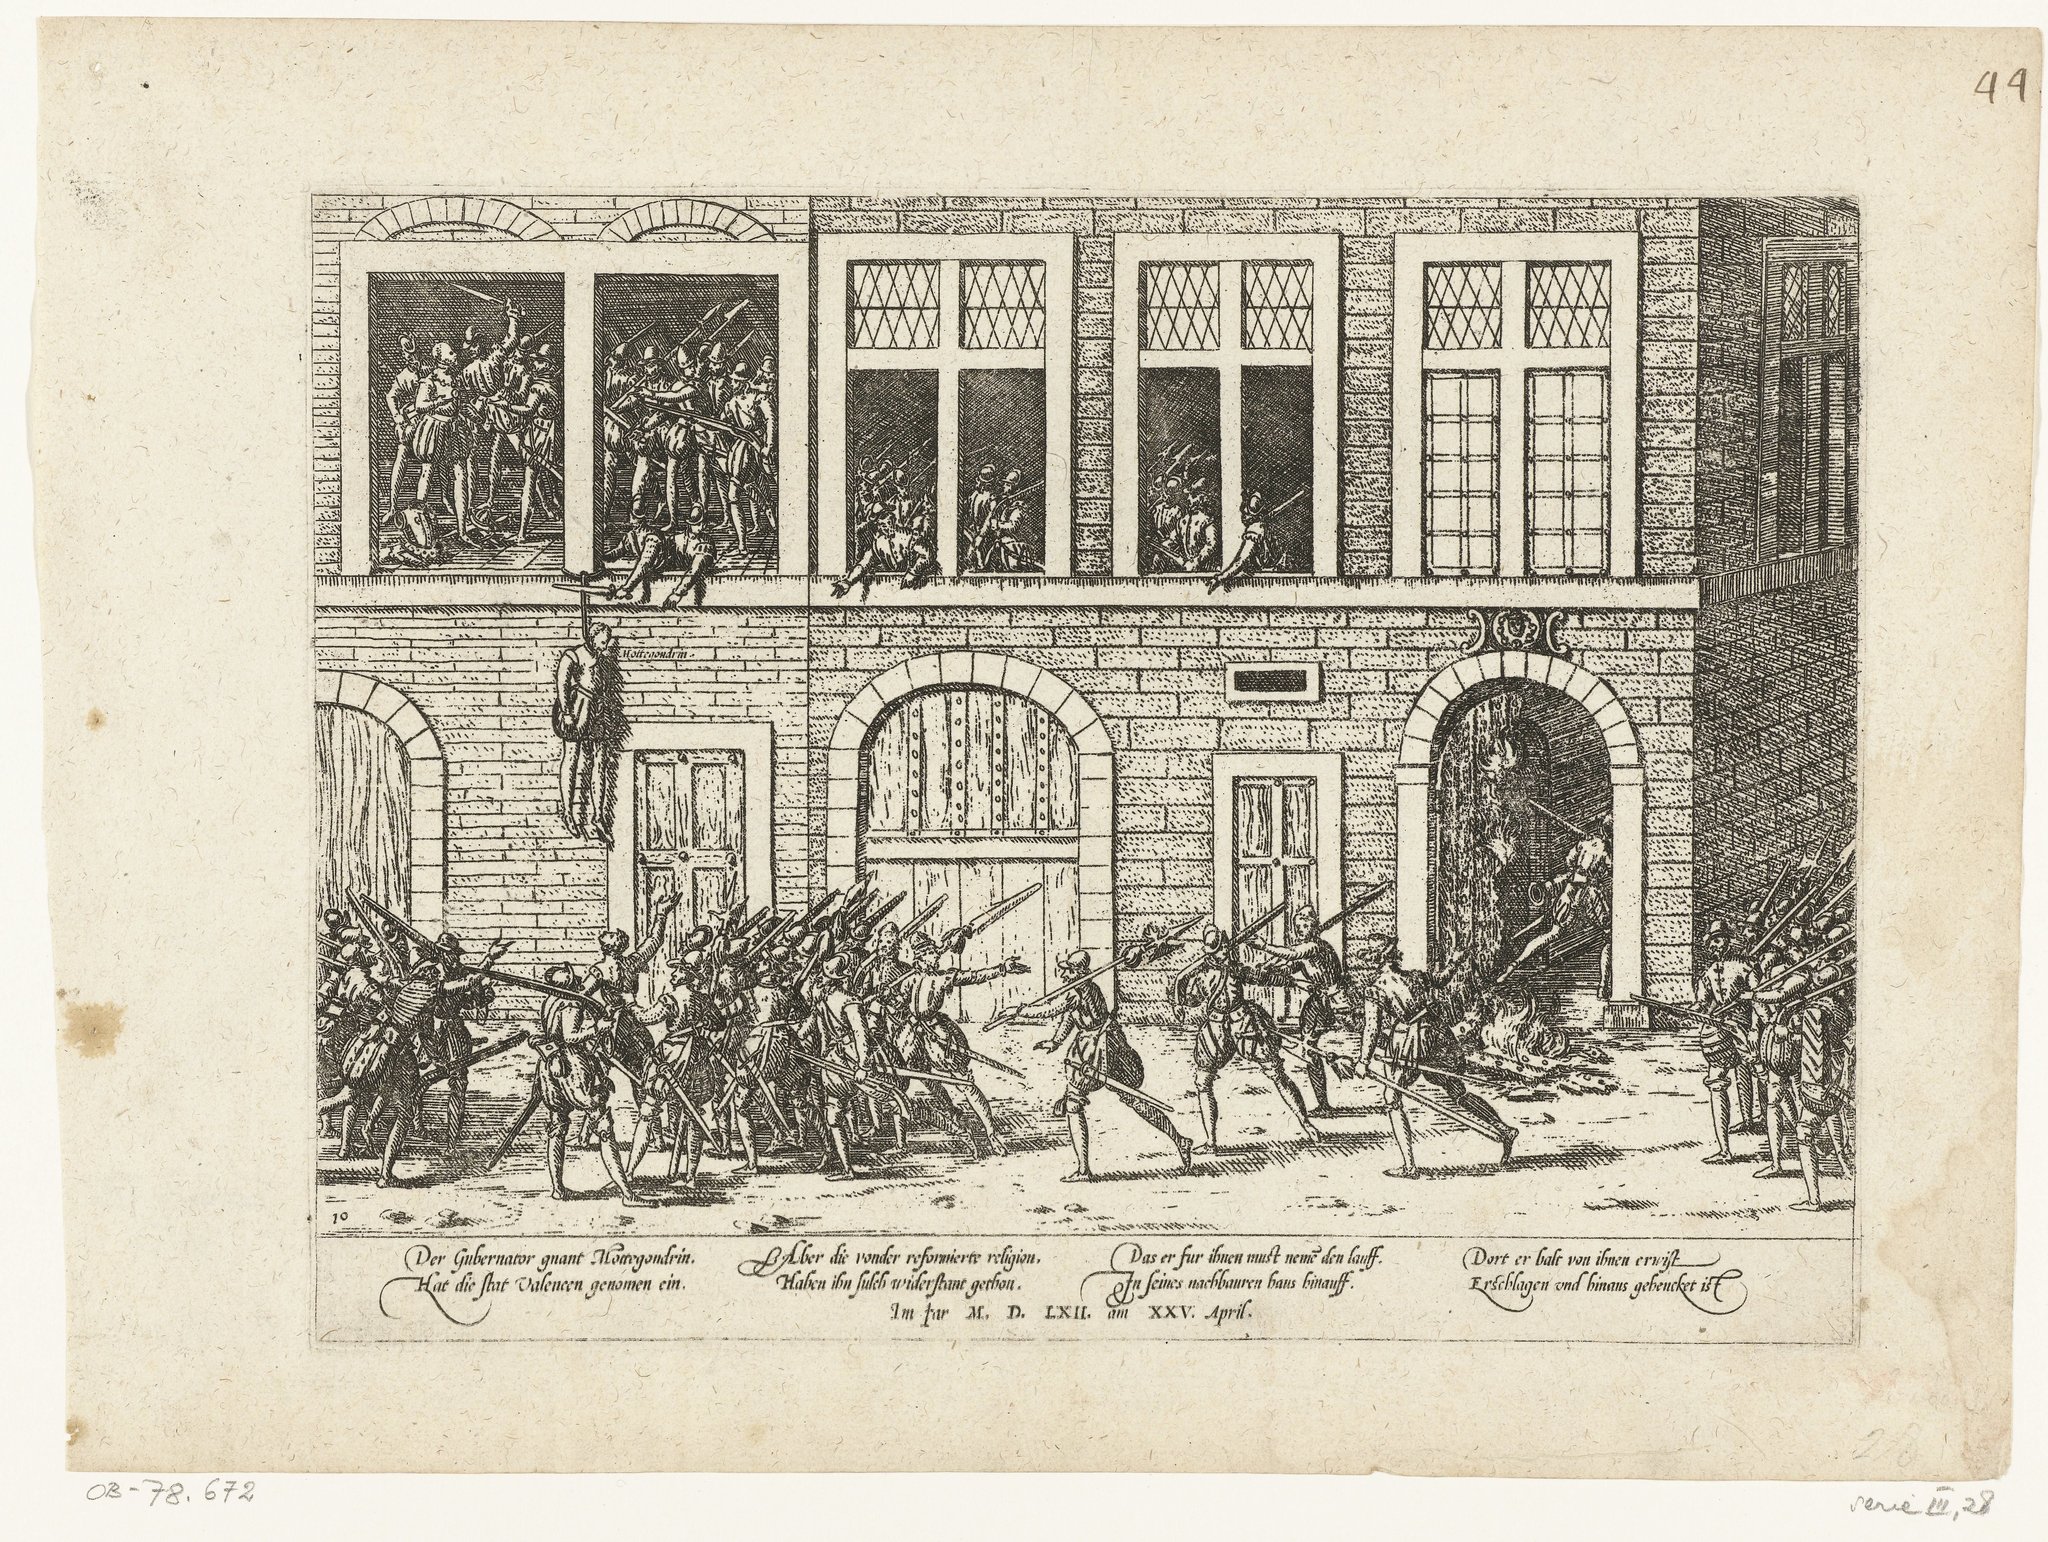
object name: print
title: La Motte-Gondrin opgehangen te Valenciennes, 1562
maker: frans hogenberg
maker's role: print maker, publisher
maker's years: 1538-1590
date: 1565-1573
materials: paper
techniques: etching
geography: cologne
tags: violent death by hanging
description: Gekopieerd naar de prent in: Jean Tortorel et Jacques Perrissin, Premier volume contenant quarante tableaux ou Histoires diverses qui sont memorables touchant les Guerres, Massacres et Troubles advenus en France en ces dernieres annees : le tout recueilly selon le tesmoignange de ceux qui y ont esté en personne et qui les ont veus : lesquels sont pourtraits à la vérité, Genève ca. 1570. Bibliotheek Rijksmuseum: 329 A 2, pl. 13.